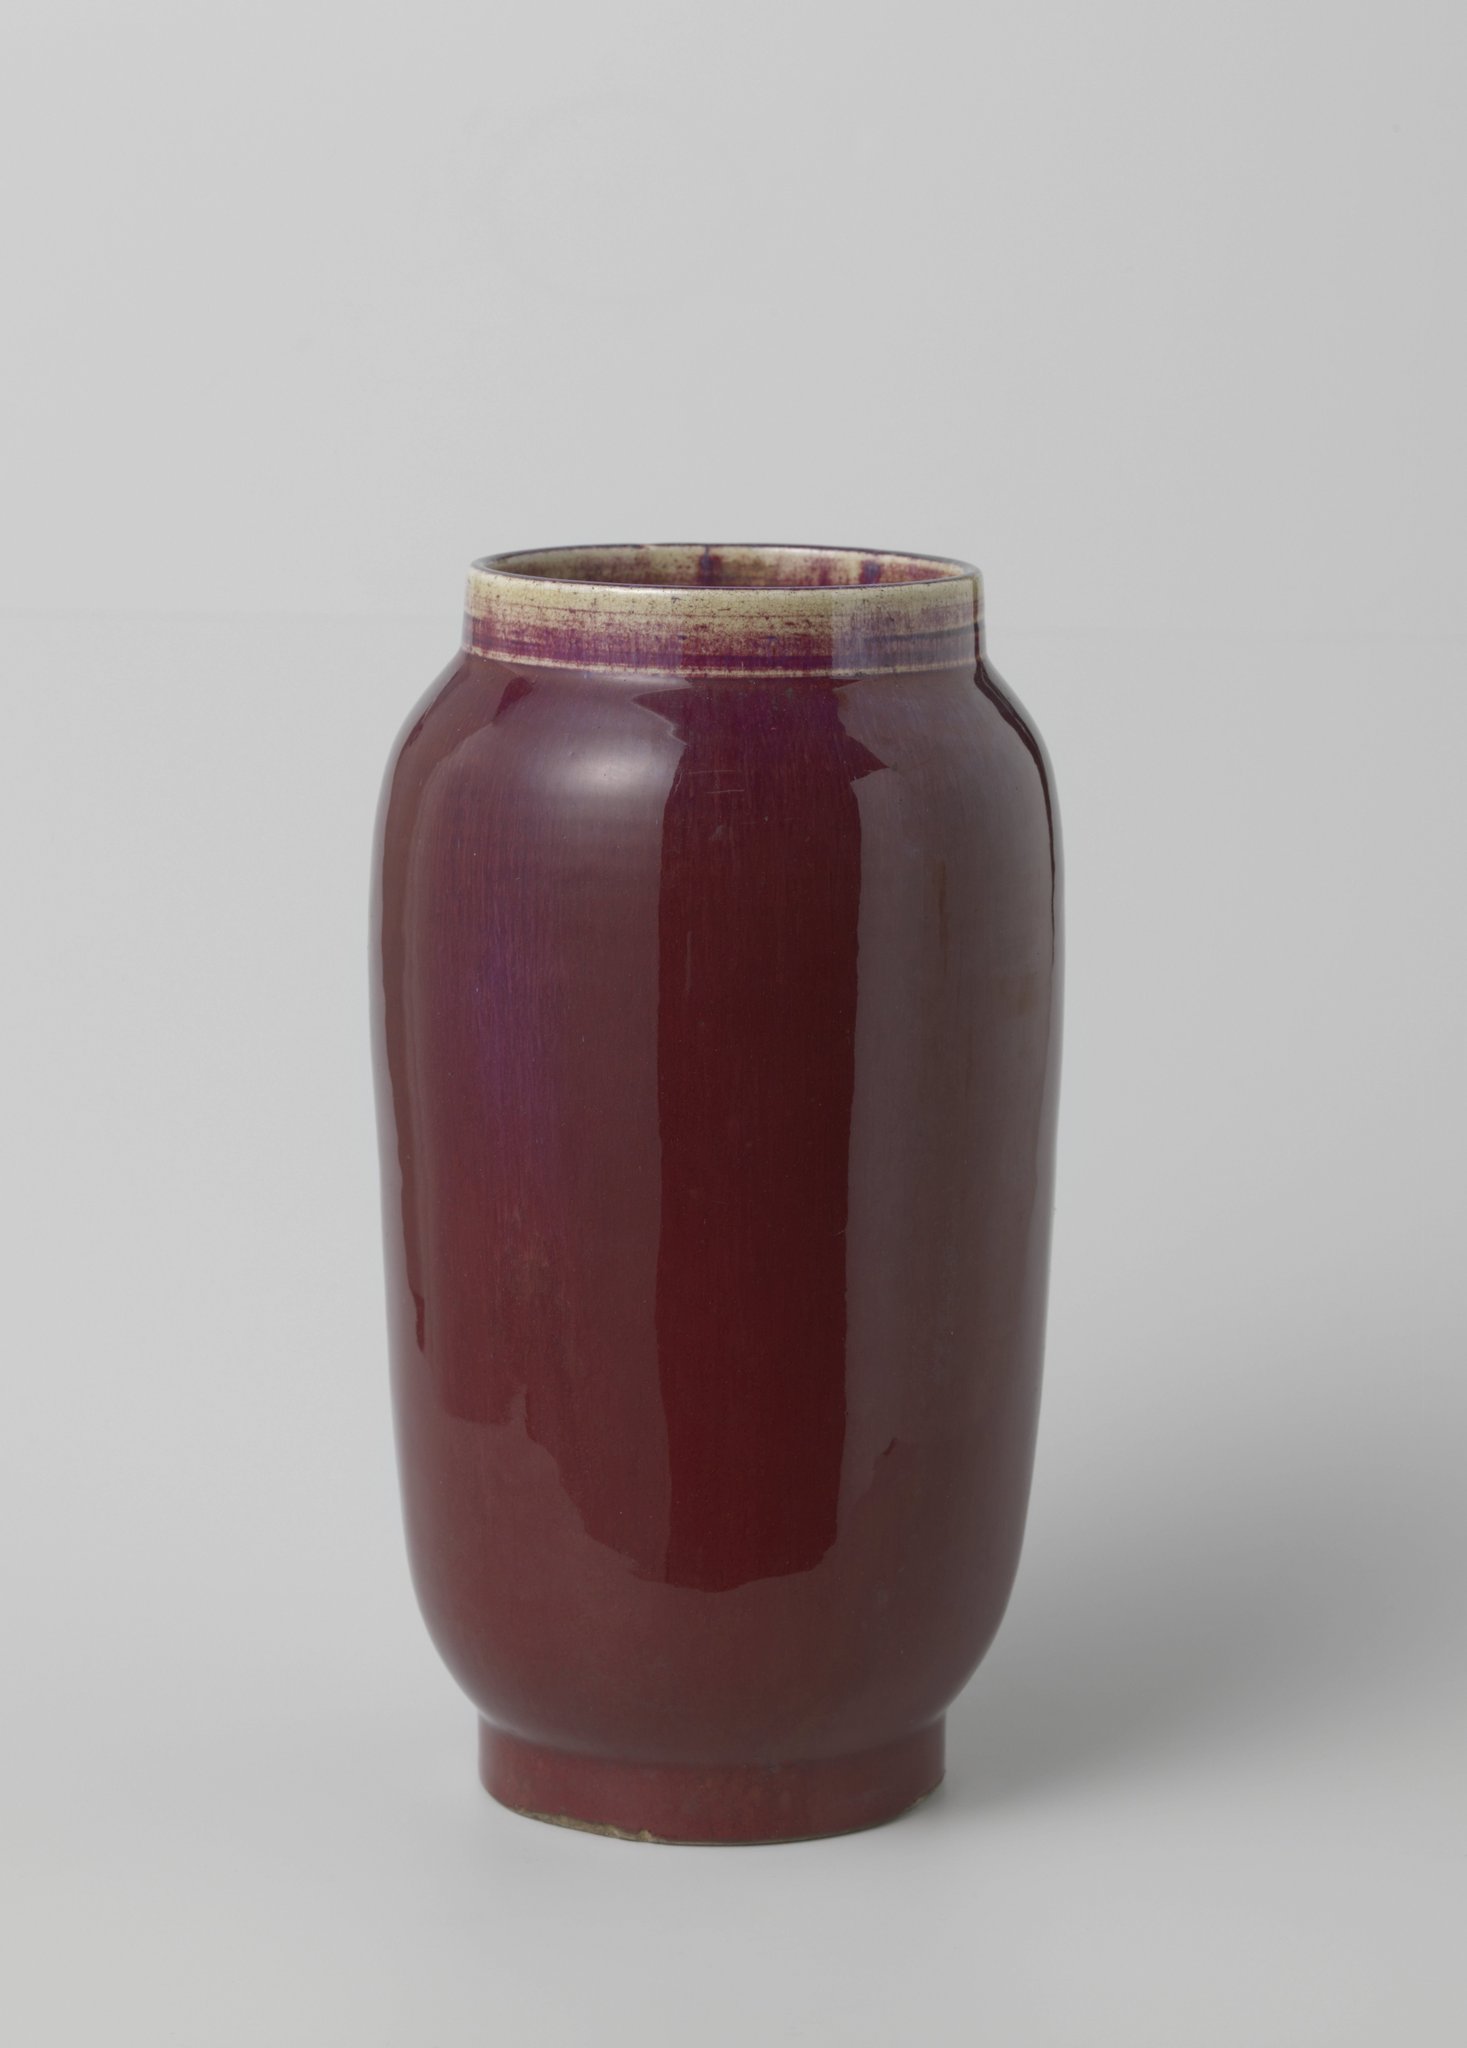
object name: vase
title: Elongated, ovoid vase with a red glaze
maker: Anonymous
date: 1800-1899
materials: glaze, porcelain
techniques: firing, turning, vitrification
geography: china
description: Lange, eivormige vaas van porselein met een korte, wijde nek, bedekt met een monochroom, licht gecraqueleerd rood (sang de boeuf) glazuur. Binnen de voetring wit geglazuurd. Monochromen.